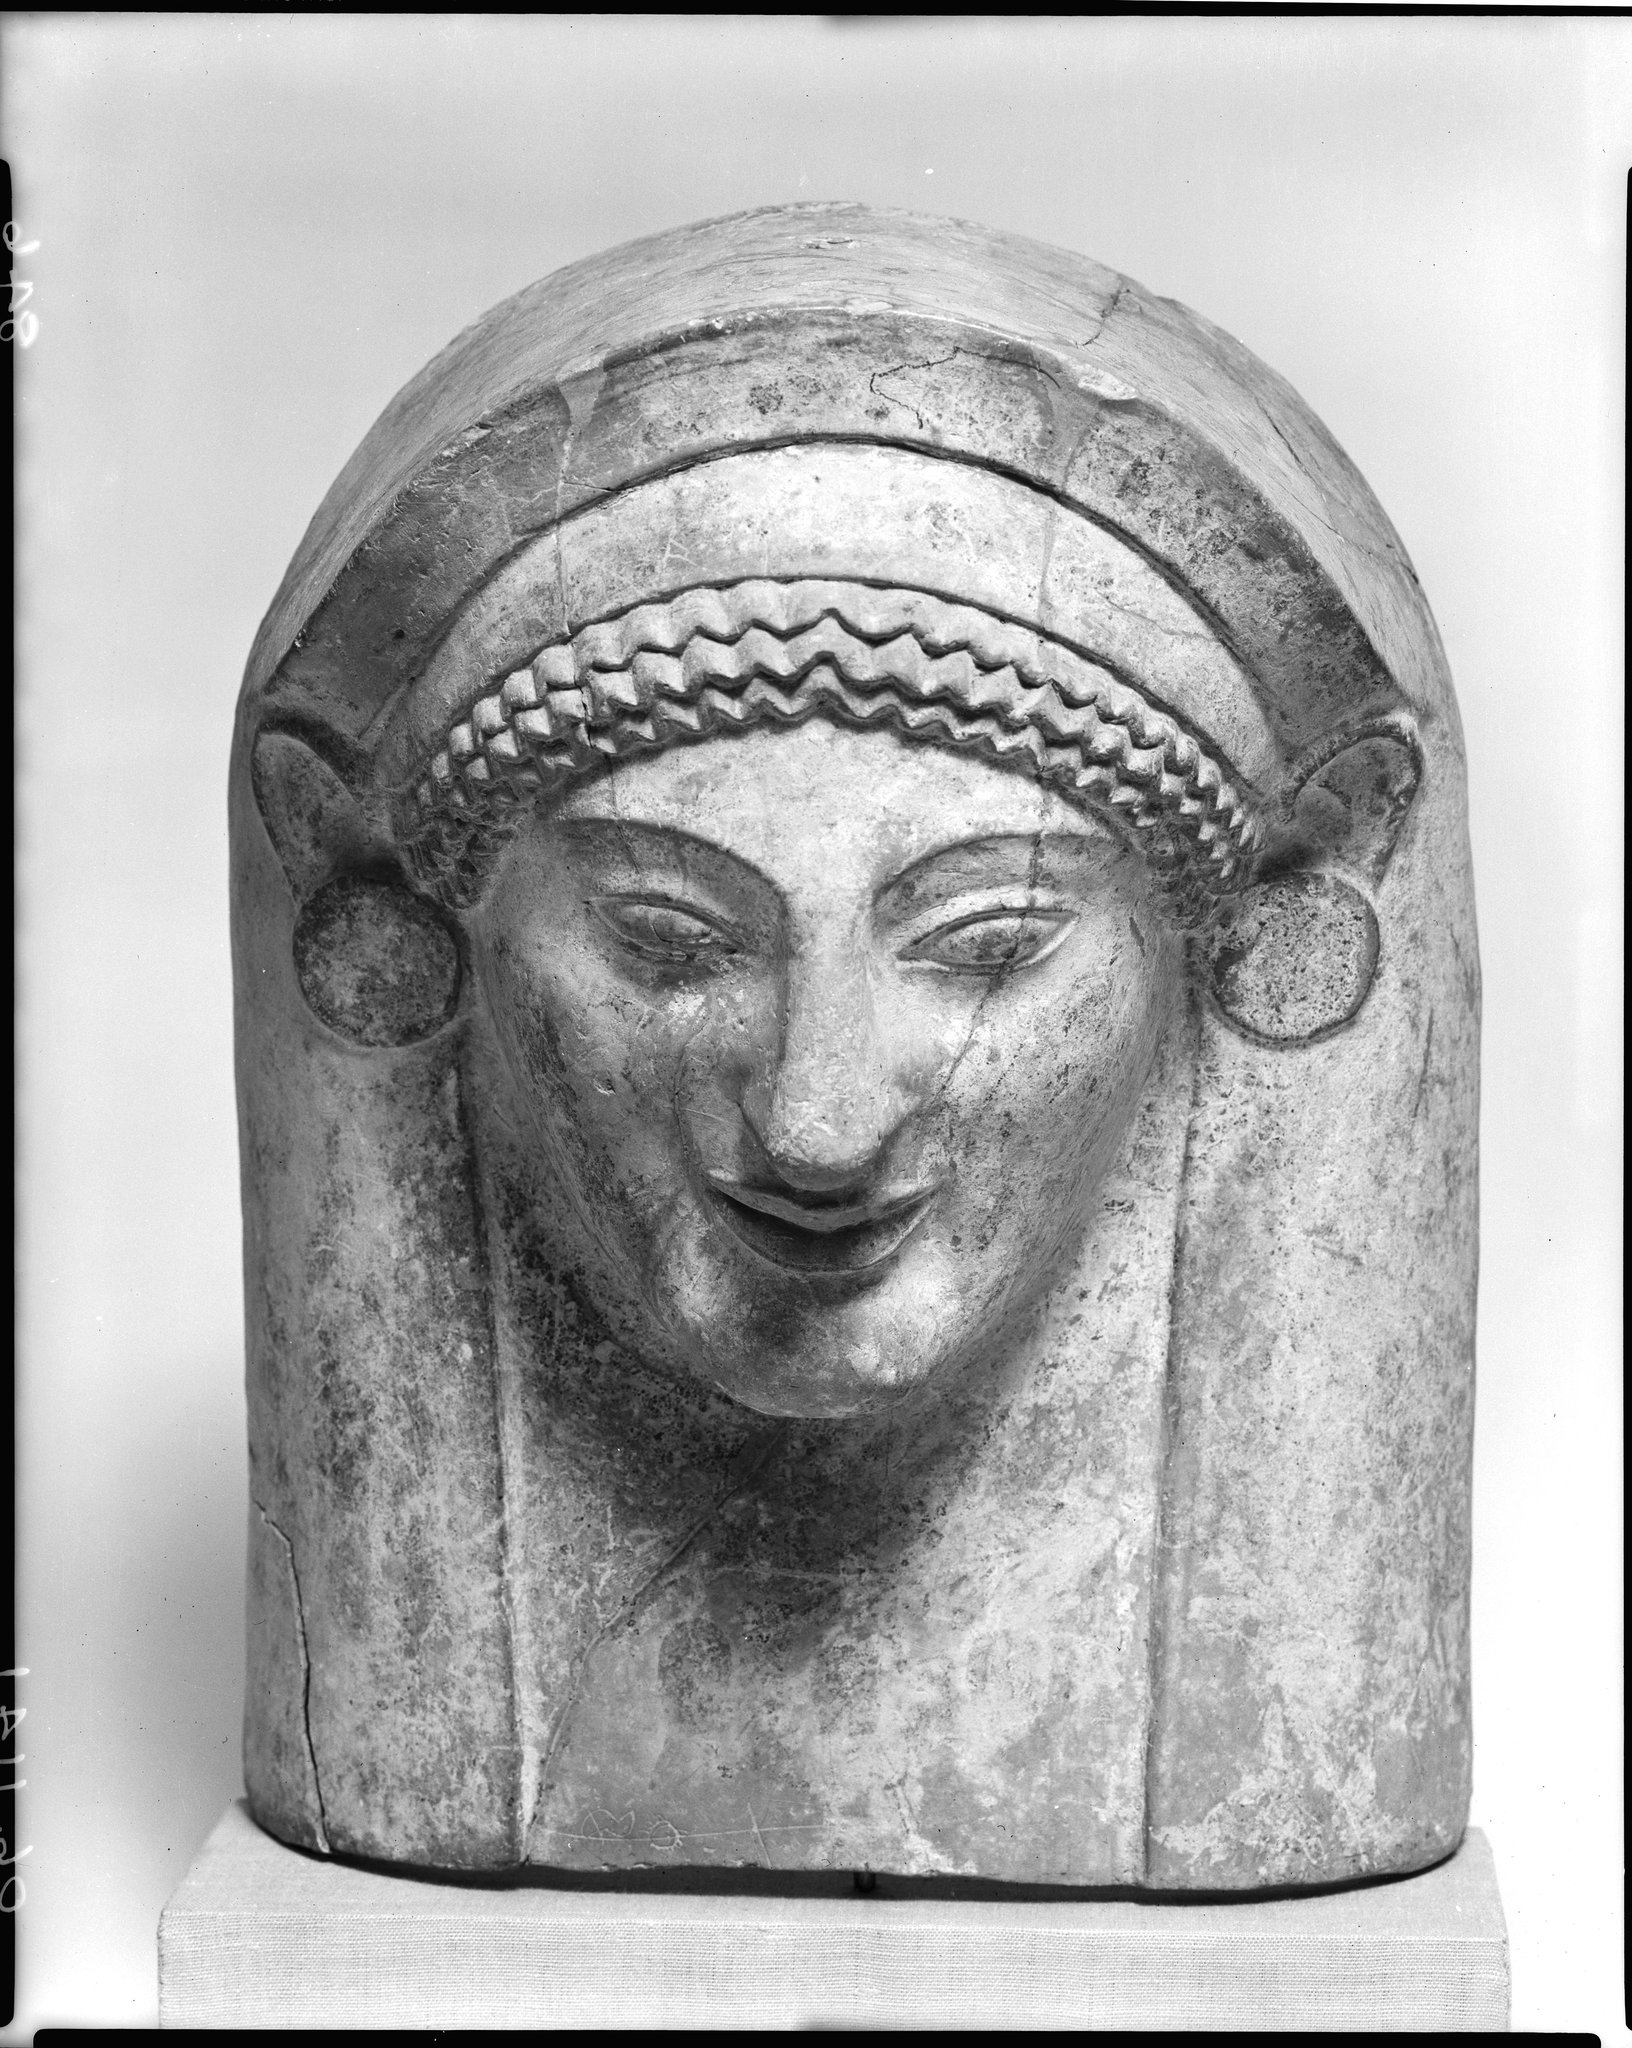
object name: protome of a woman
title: Terracotta protome of a goddess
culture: greek, rhodian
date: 500-468 BCE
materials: terracotta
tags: heads,goddess